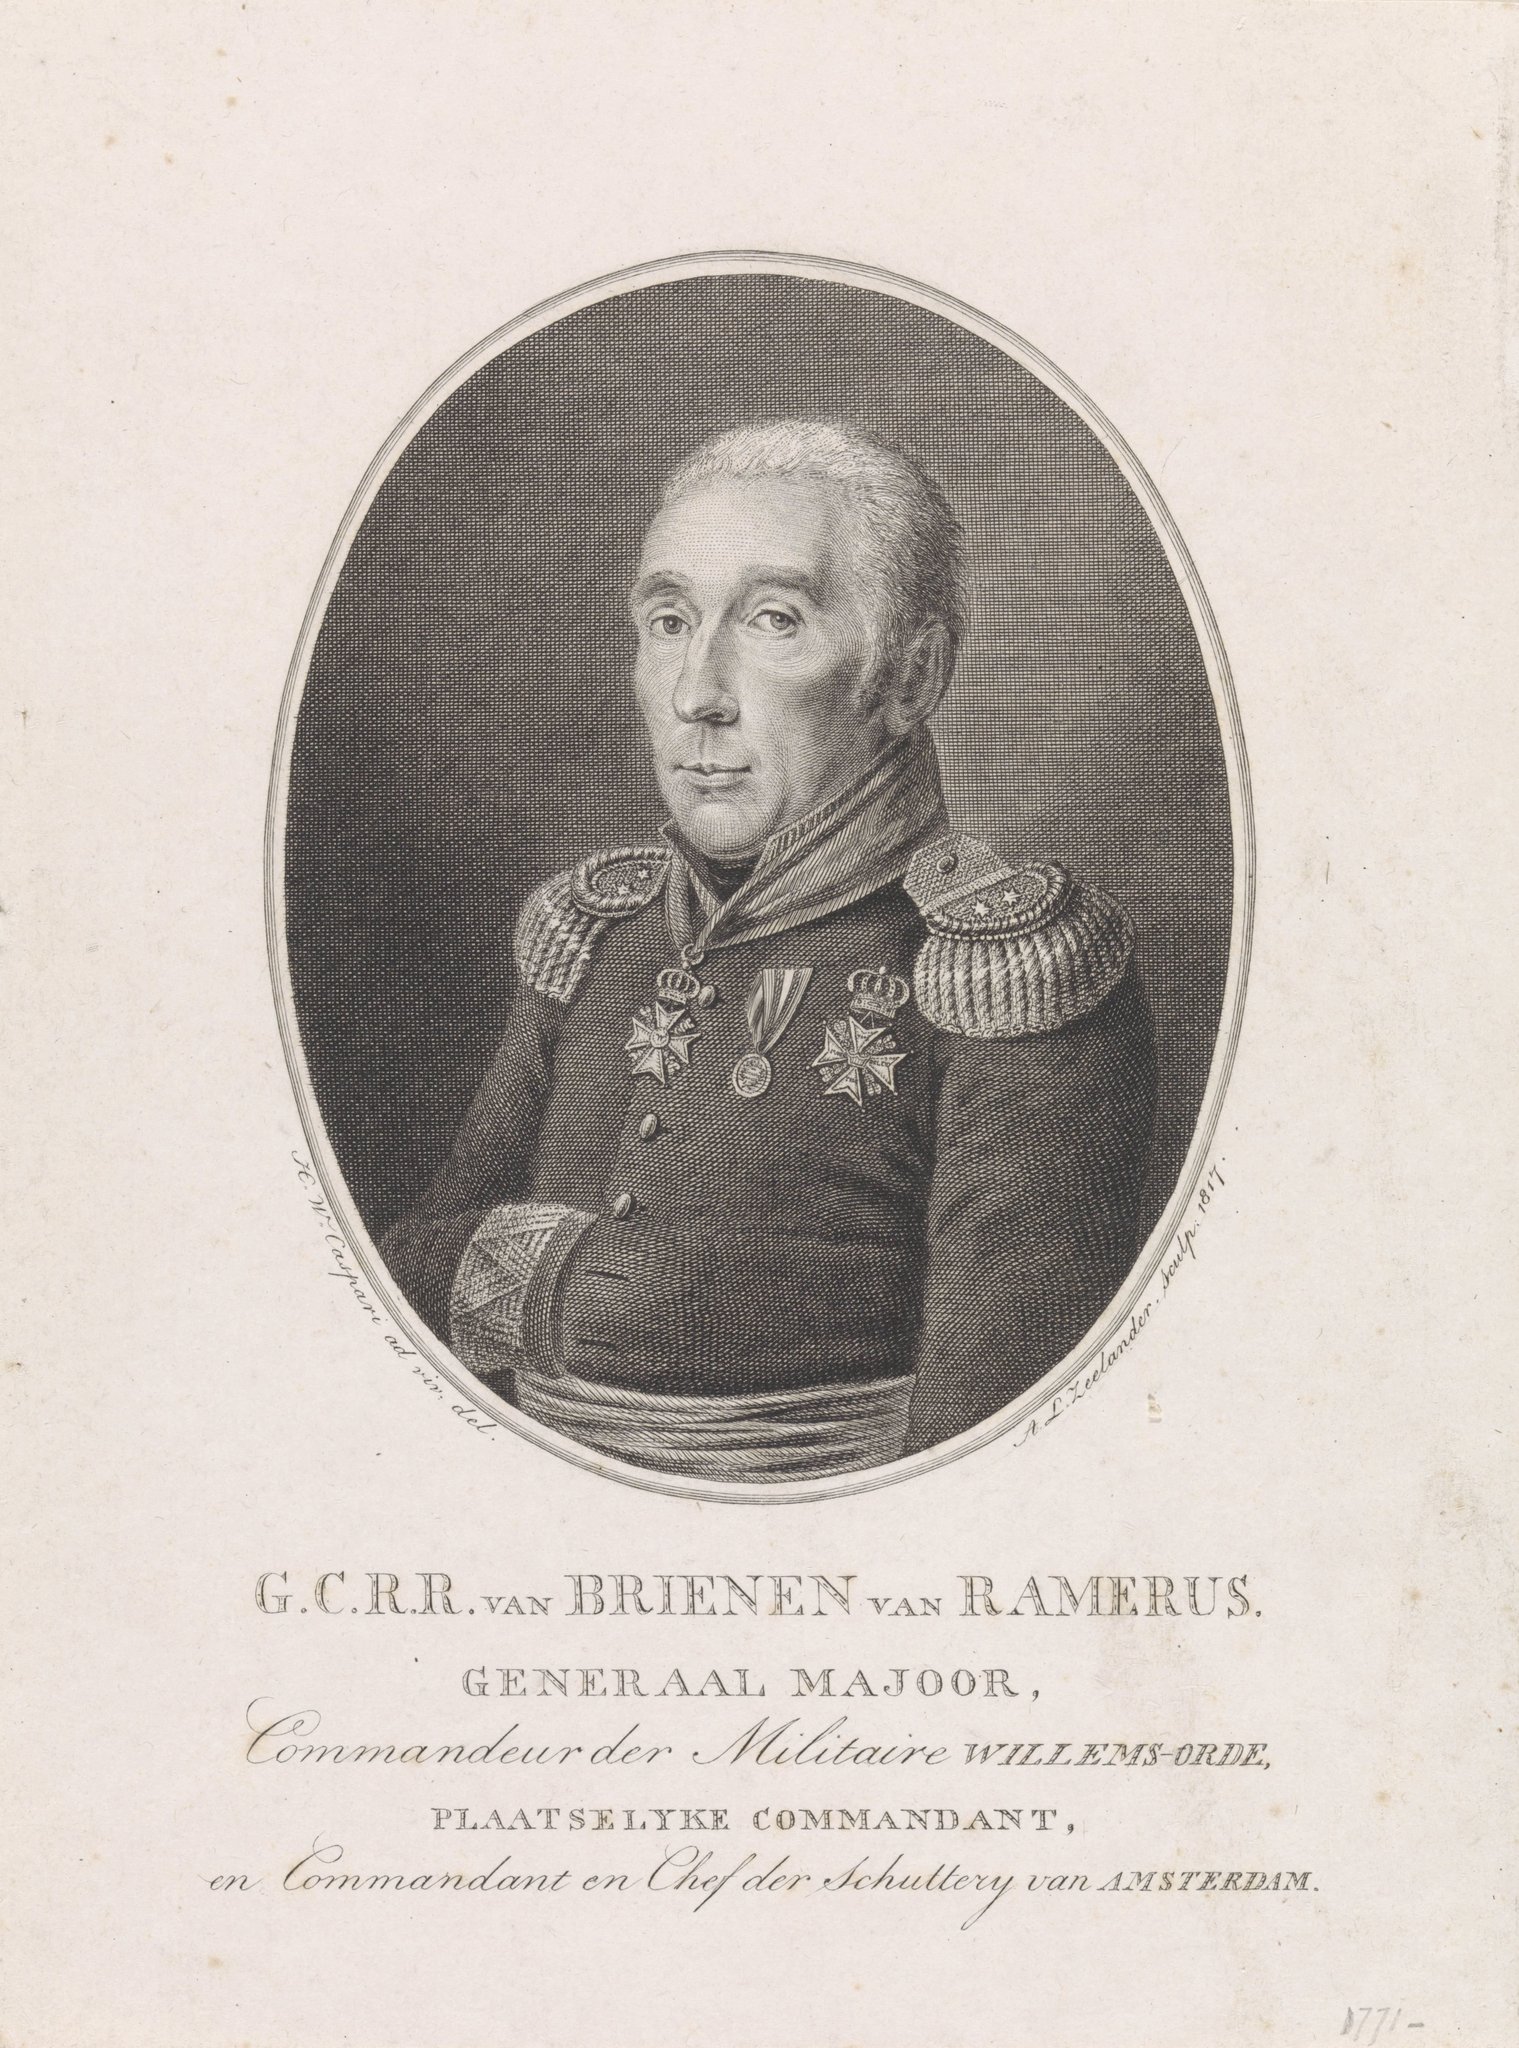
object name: print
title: Portret van Gijsbert Carel Rutger Reinier van Brienen van Ramerus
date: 1817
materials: paper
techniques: engraving, etching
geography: amsterdam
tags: gijsbert carel rutger reinier van brienen van ramerus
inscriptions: collector's mark: Lugt 2228, collector's mark: Lugt 964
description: Portret van Gijsbert Carel Rutger Reinier van Brienen van Ramerus, commandeur in de Militaire Willems-Orde.